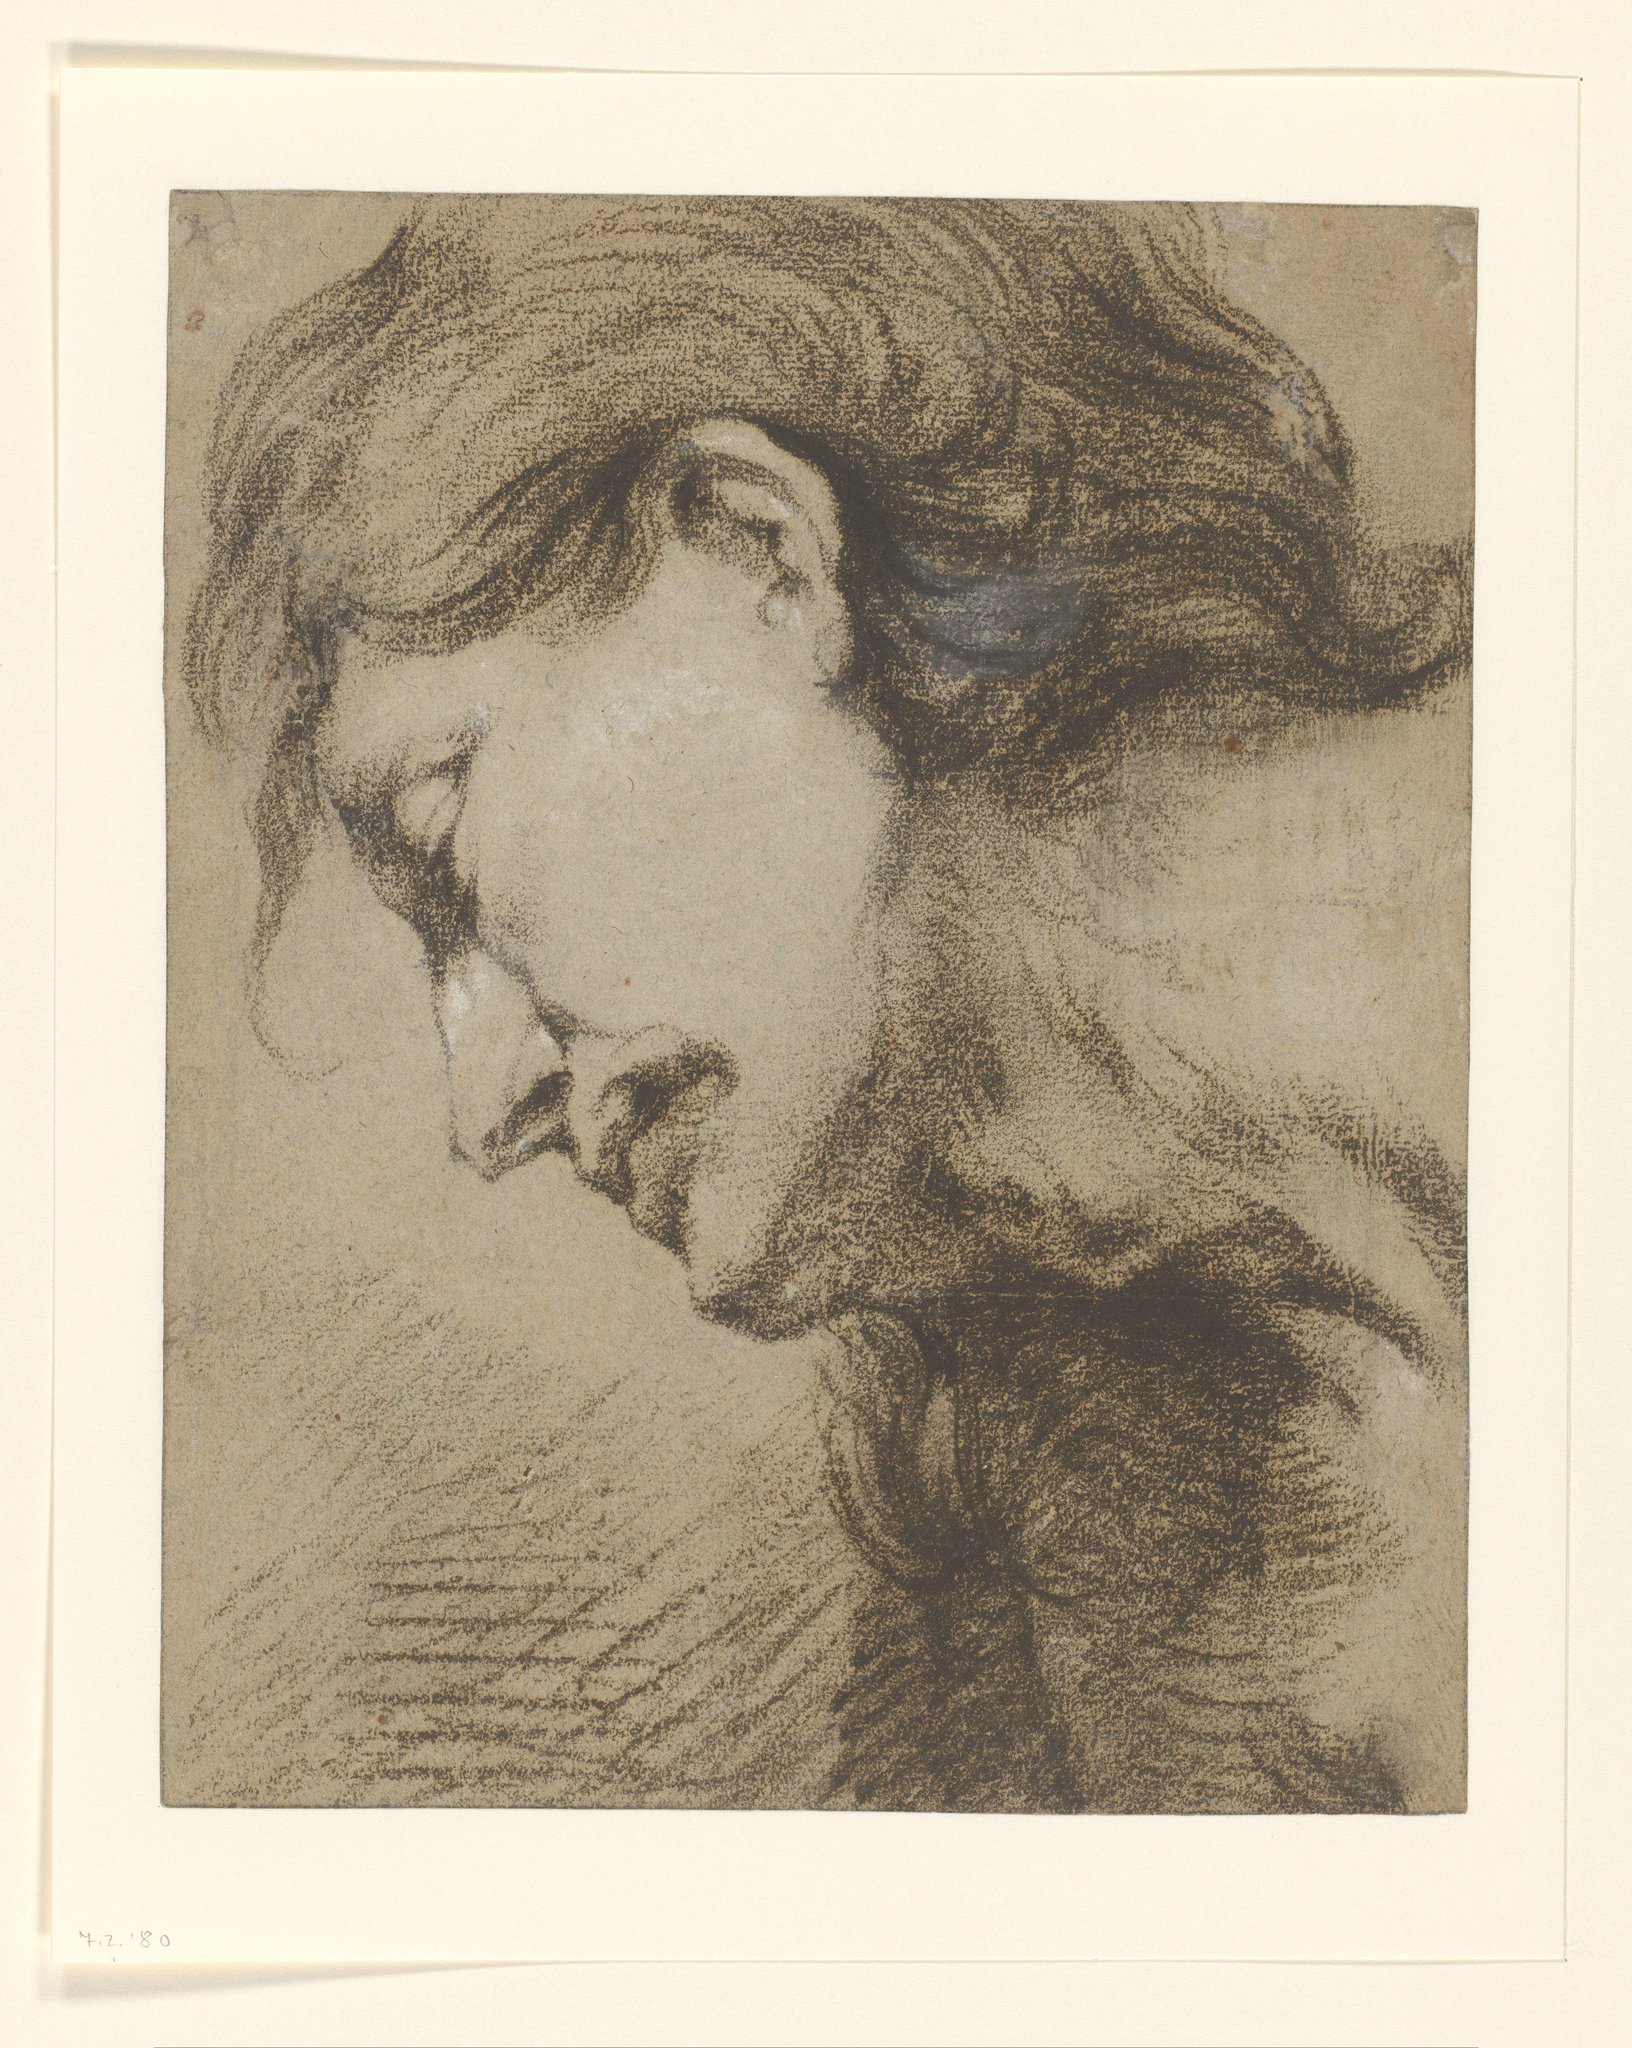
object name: drawing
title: Manskop met lang haar, omlaag kijkend naar links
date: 1610-1641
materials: chalk, paper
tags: head (human)